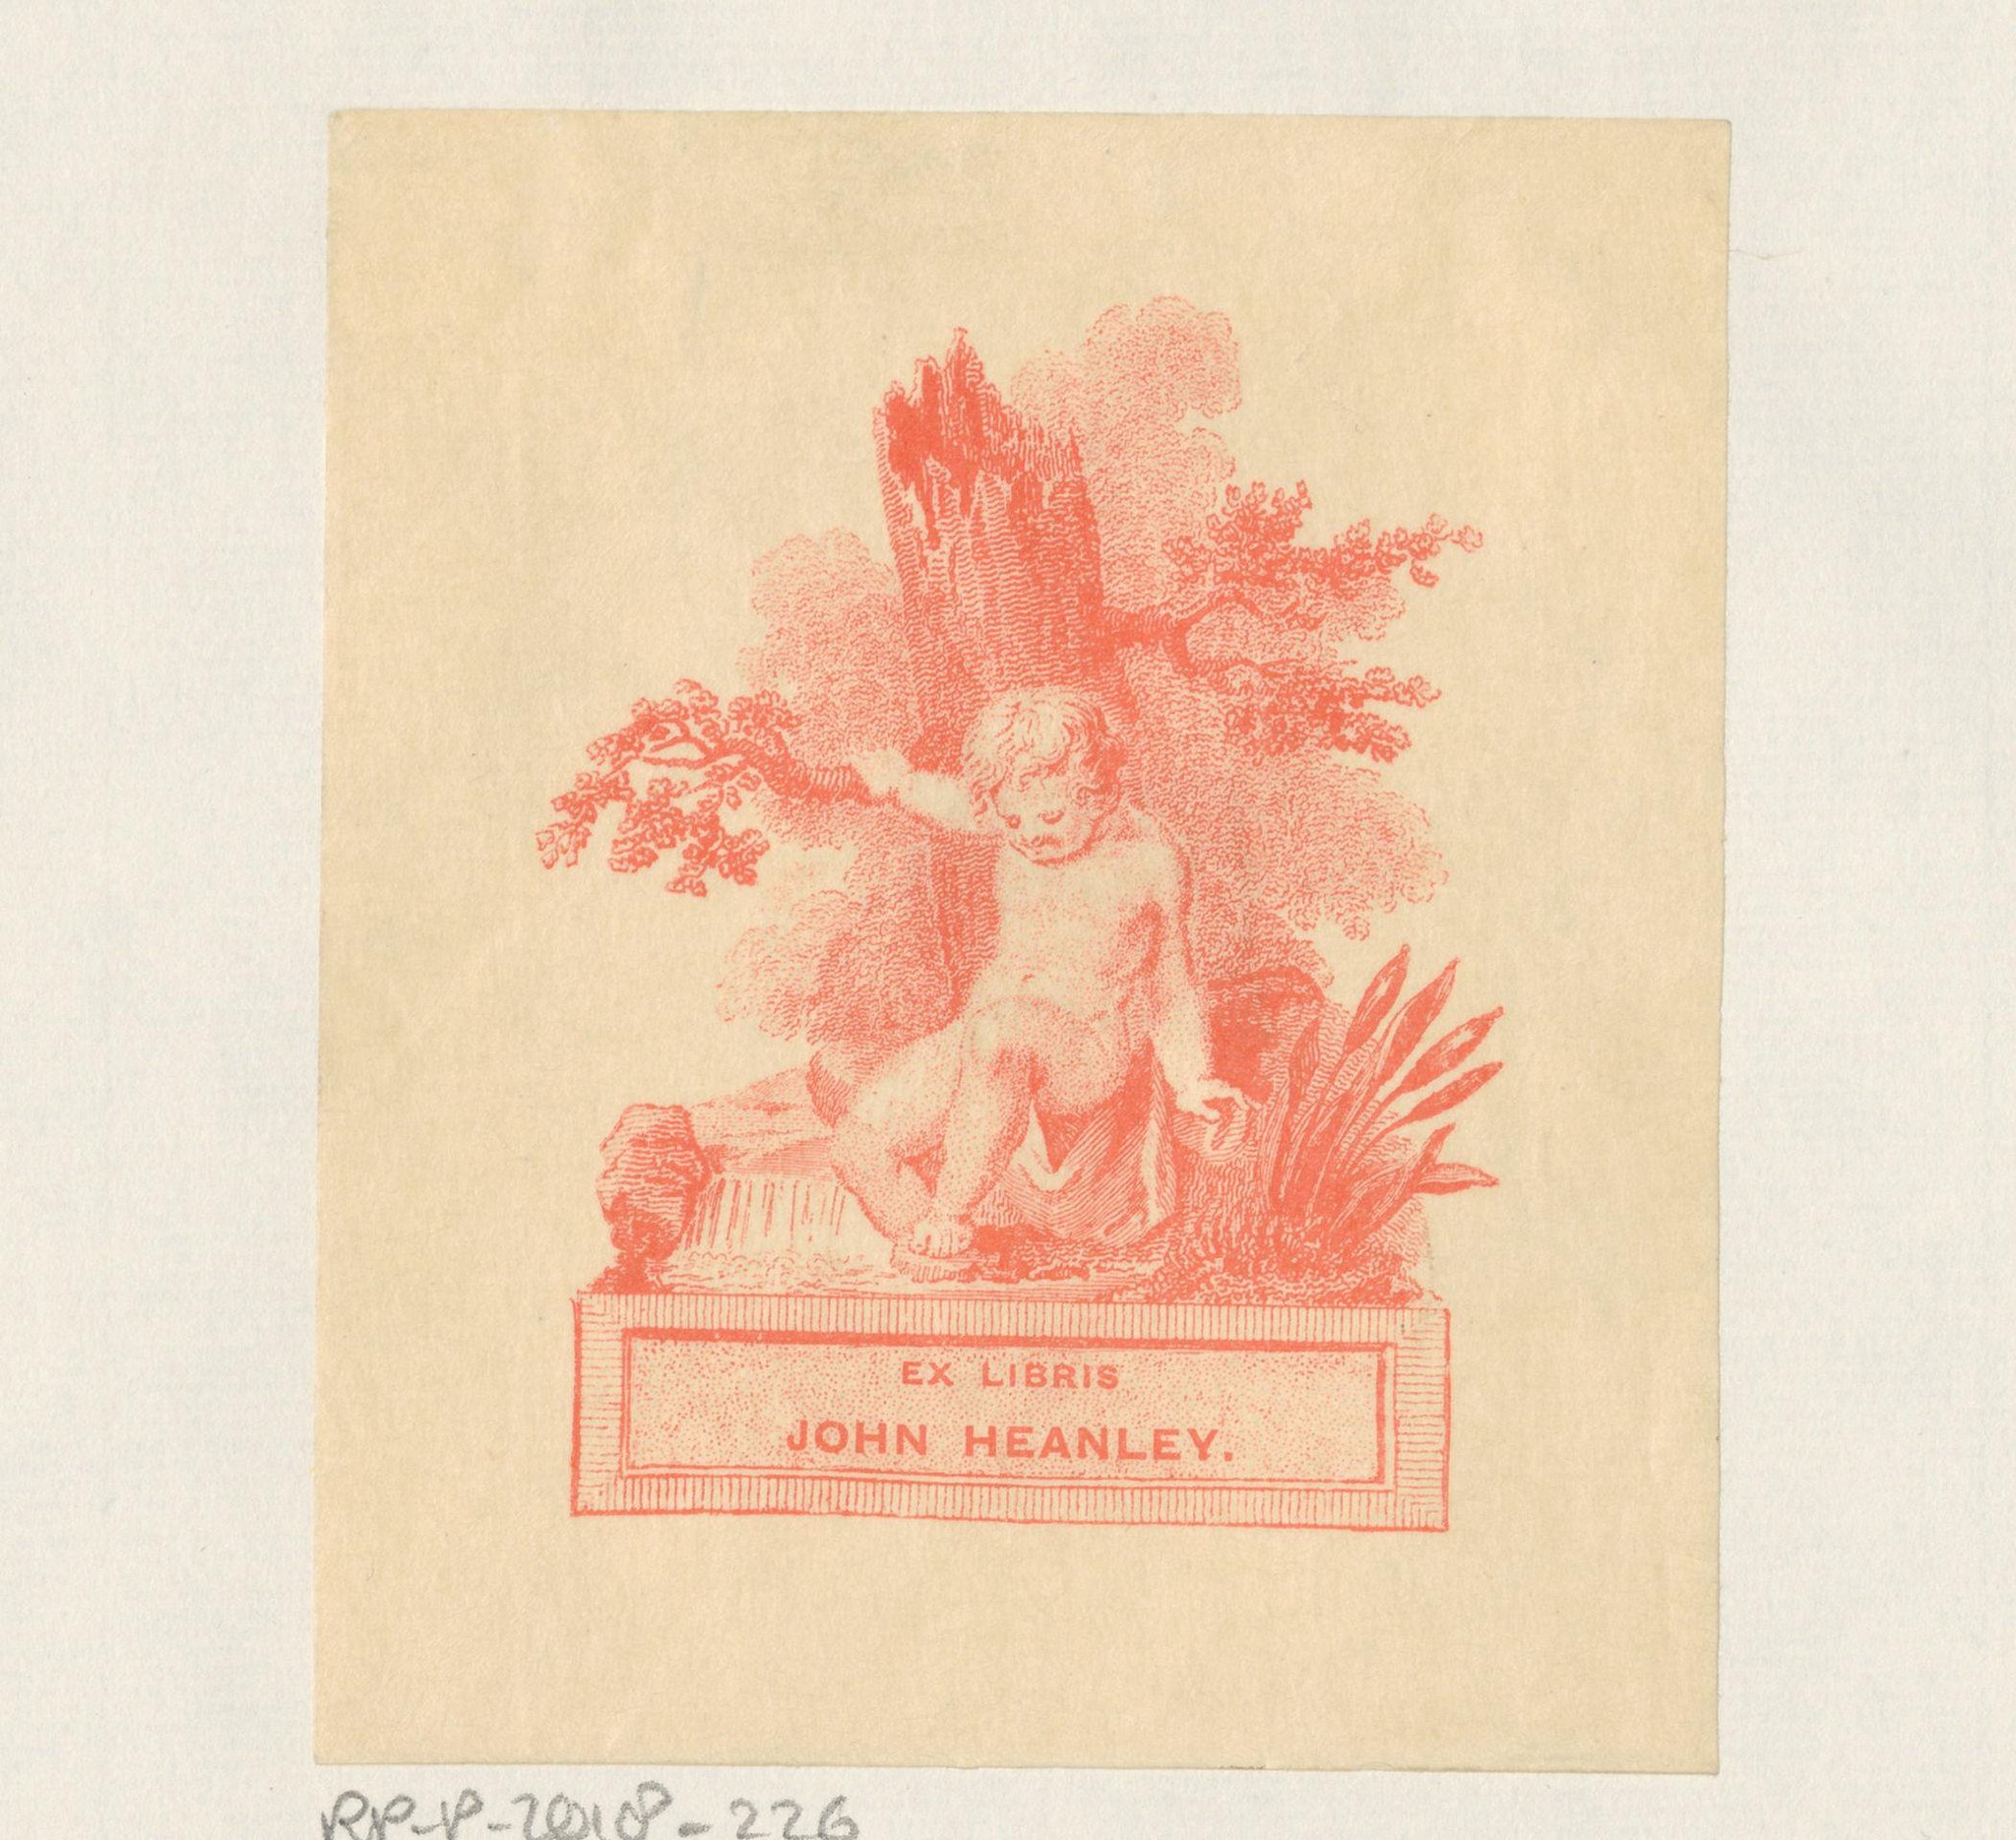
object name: bookplate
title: Ex libris van John Heanley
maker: Anonymous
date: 1870-1939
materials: paper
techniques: printing block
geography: england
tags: trees, waterfall, infant, baby